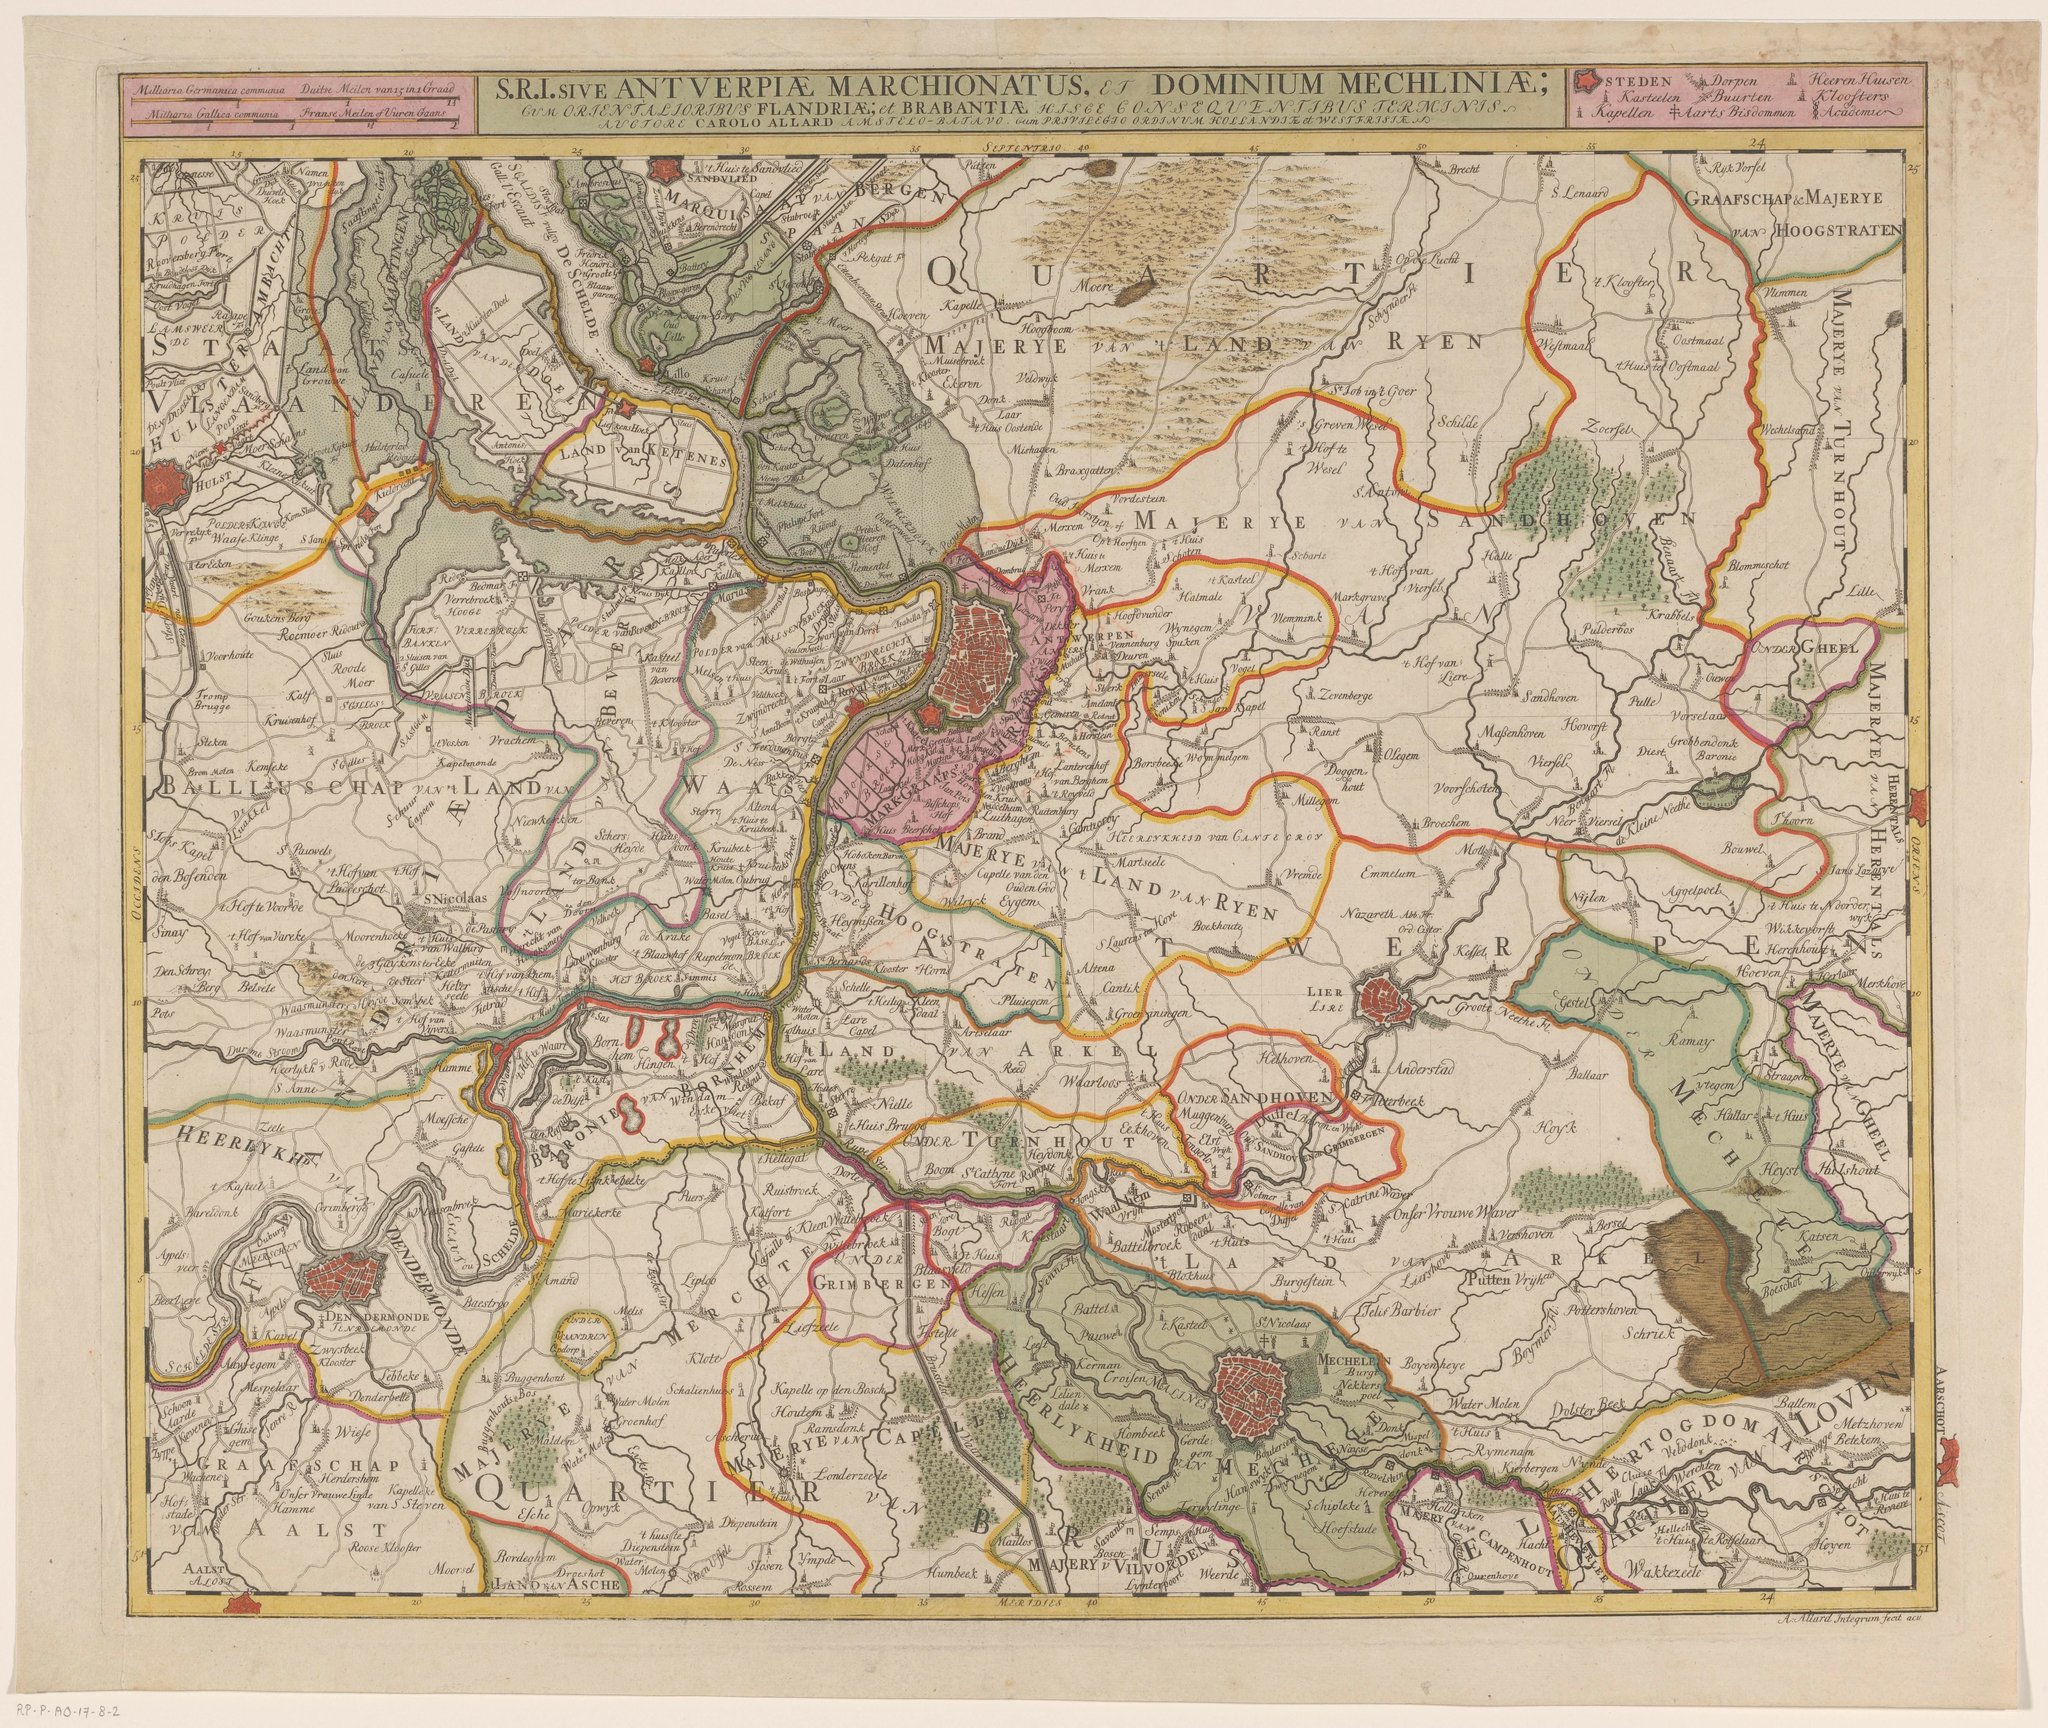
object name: map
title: Kaart van het kwartier van Antwerpen, onderdeel van het hertogdom Brabant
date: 1690-1709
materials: paper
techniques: engraving, etching, hand coloring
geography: amsterdam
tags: maps of separate countries or regions, brabant, antwerp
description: Kaart van het kwartier van Antwerpen, één van de vier kwartieren waarin het hertogdom Brabant is verdeeld. In een balk boven de kaart, in het midden, de titel. Links hiervan twee schaalstokken: 1 1/2 Duitse Meilen van 15 in 1 Graad / 2 Franse Meilen of Uuren Gaans. Rechts van de titel een legenda. De kaart is voorzien van een coördinaten-net en een gradenverdeling.